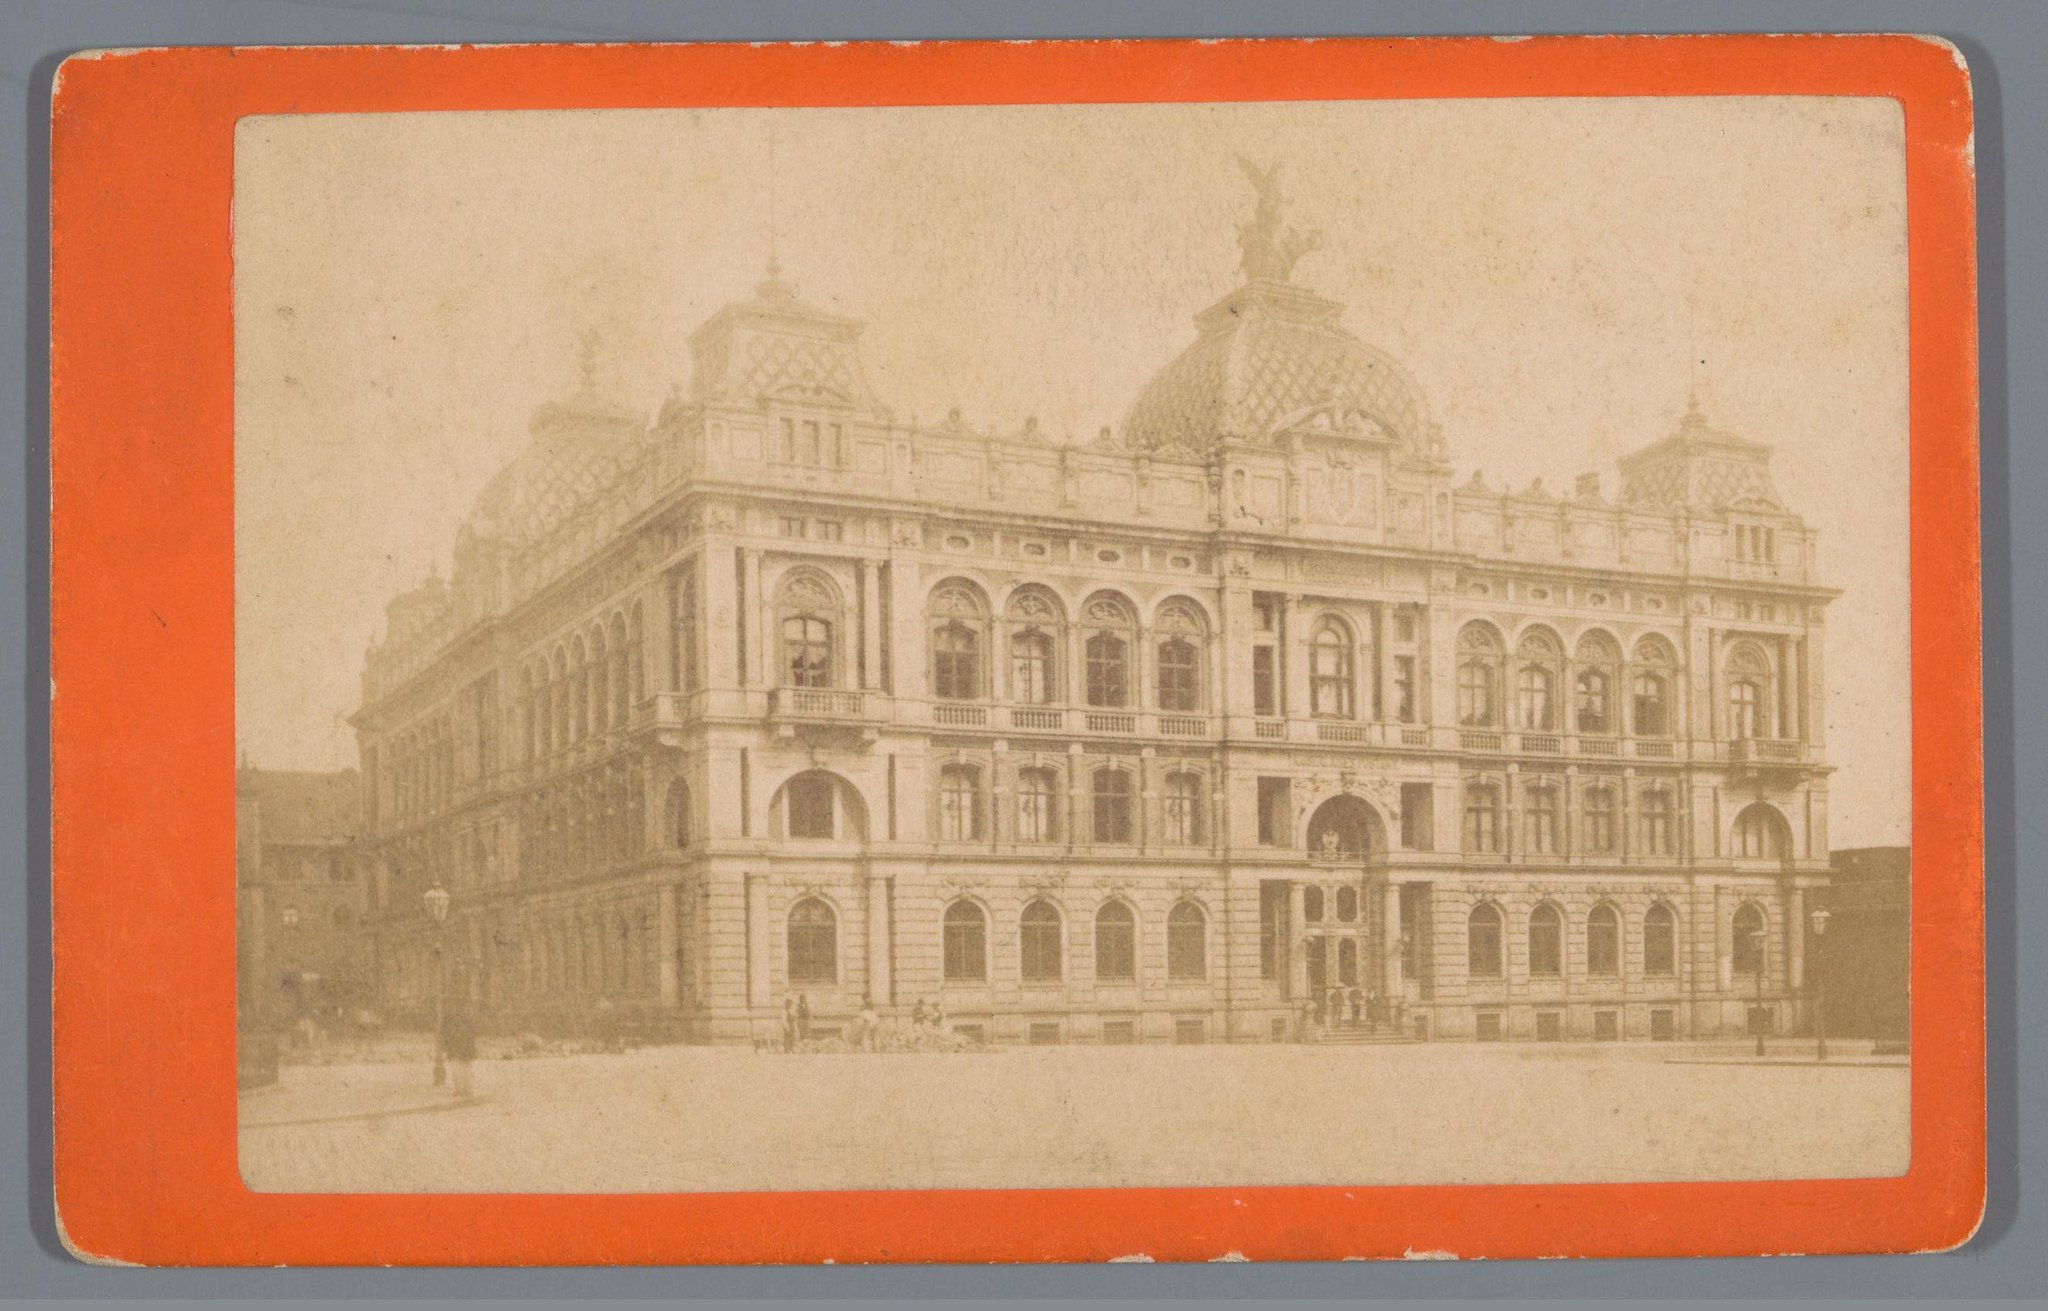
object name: photograph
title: Paleis in een stad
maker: Anonymous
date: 1854-1885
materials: cardboard, paper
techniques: albumen print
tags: palace